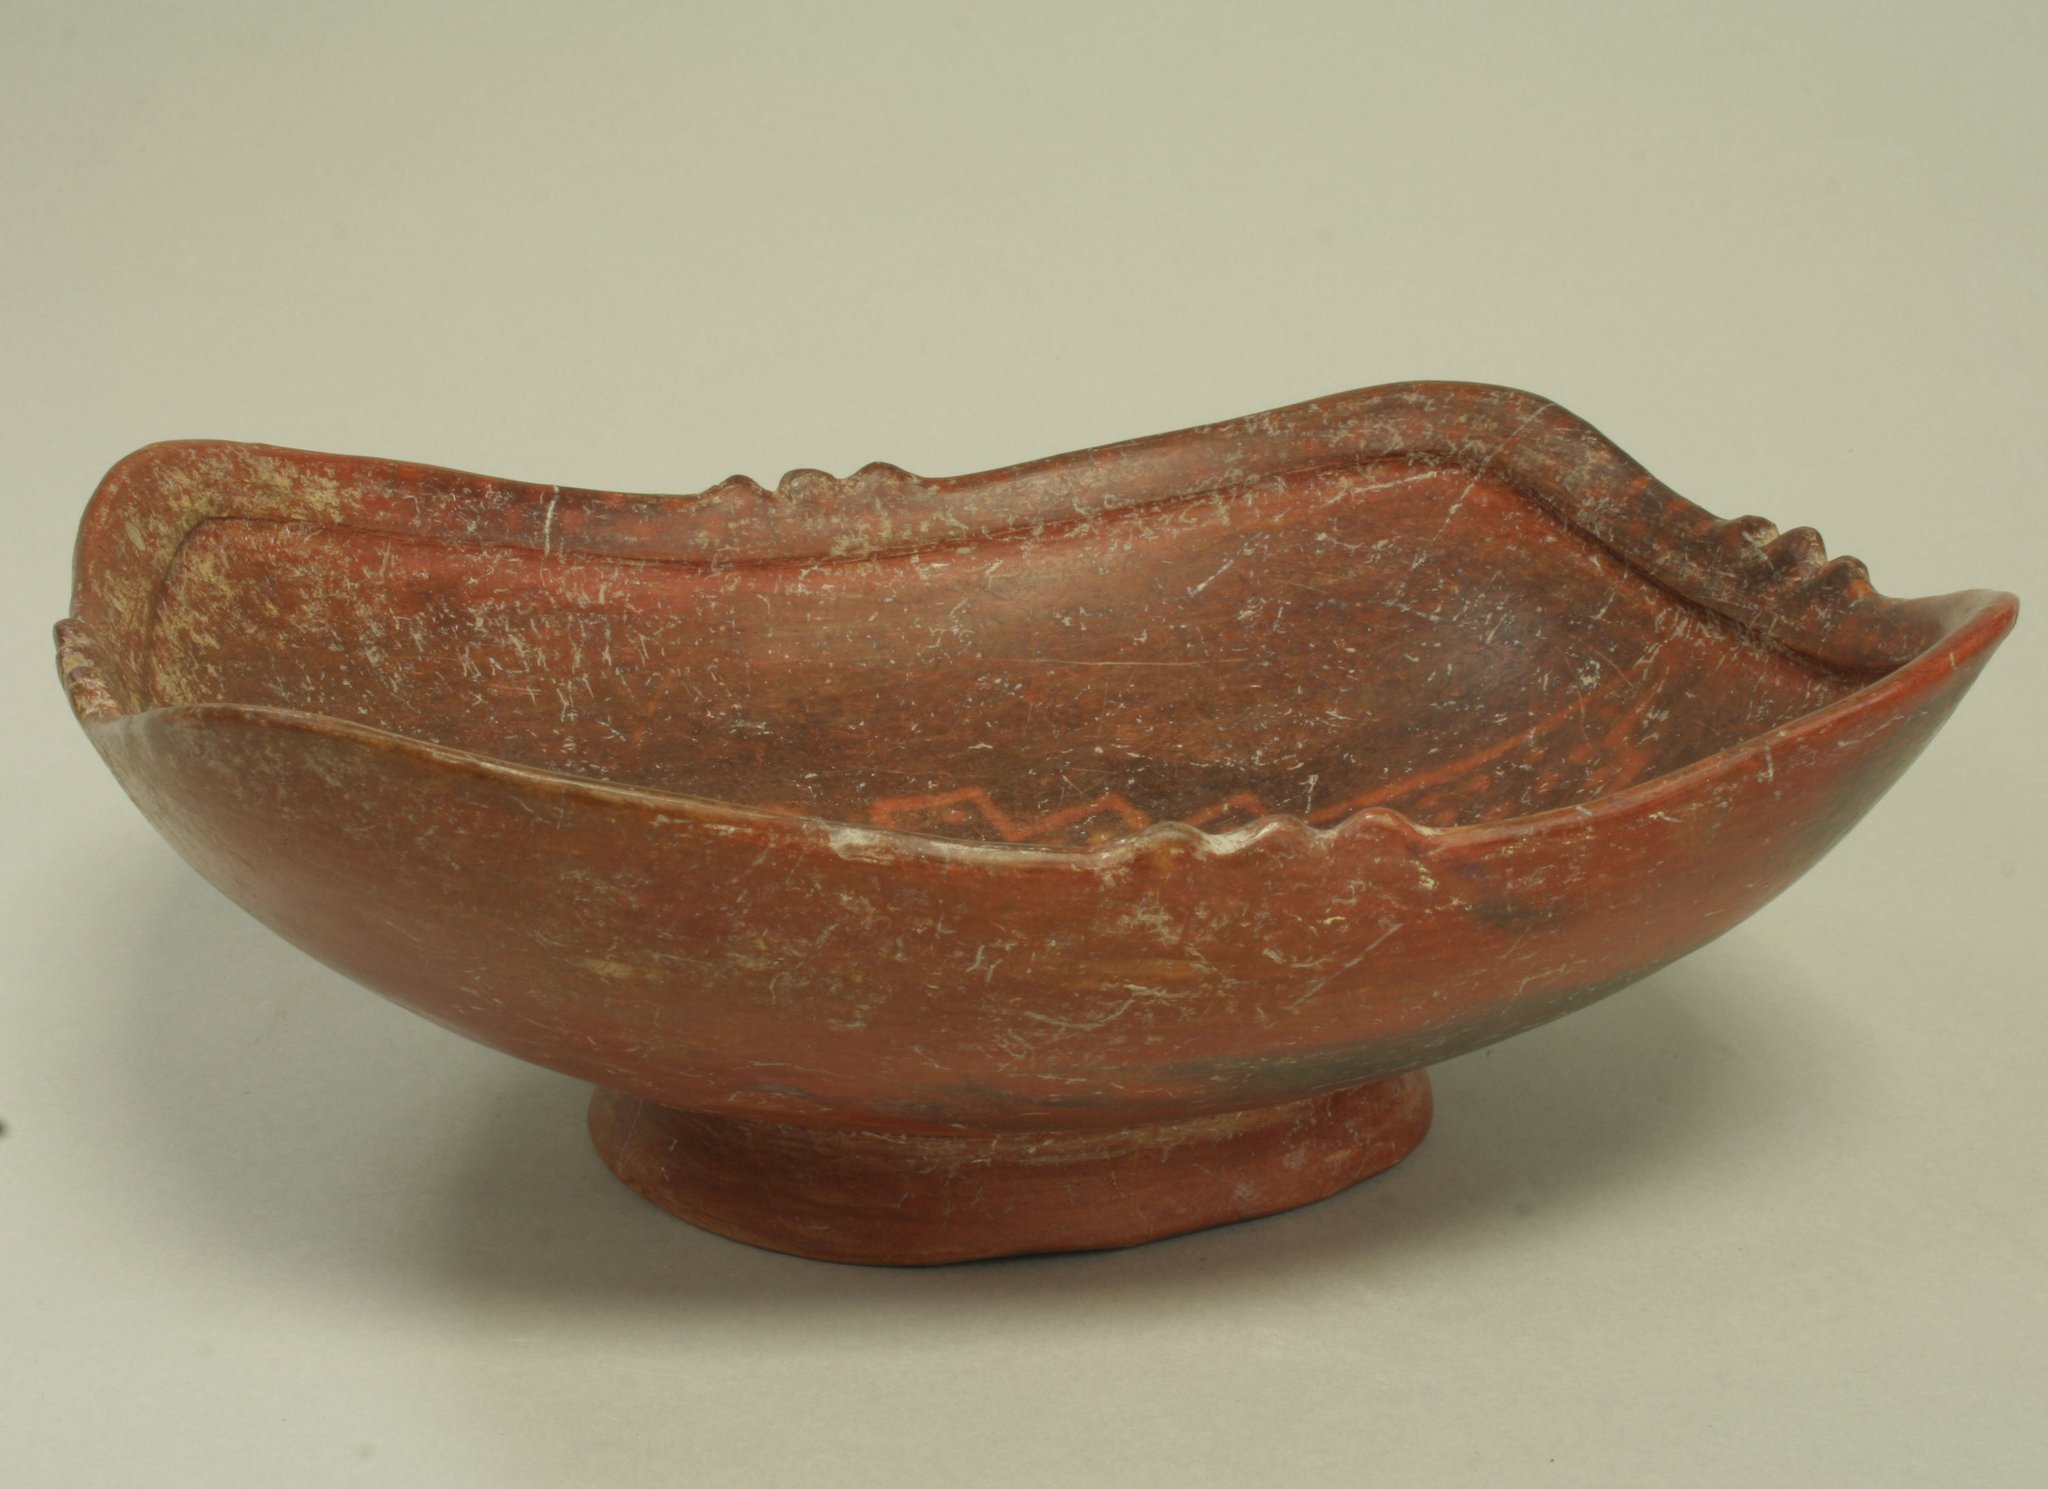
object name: bowl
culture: chorrera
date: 900-101 BCE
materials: ceramic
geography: ecuador